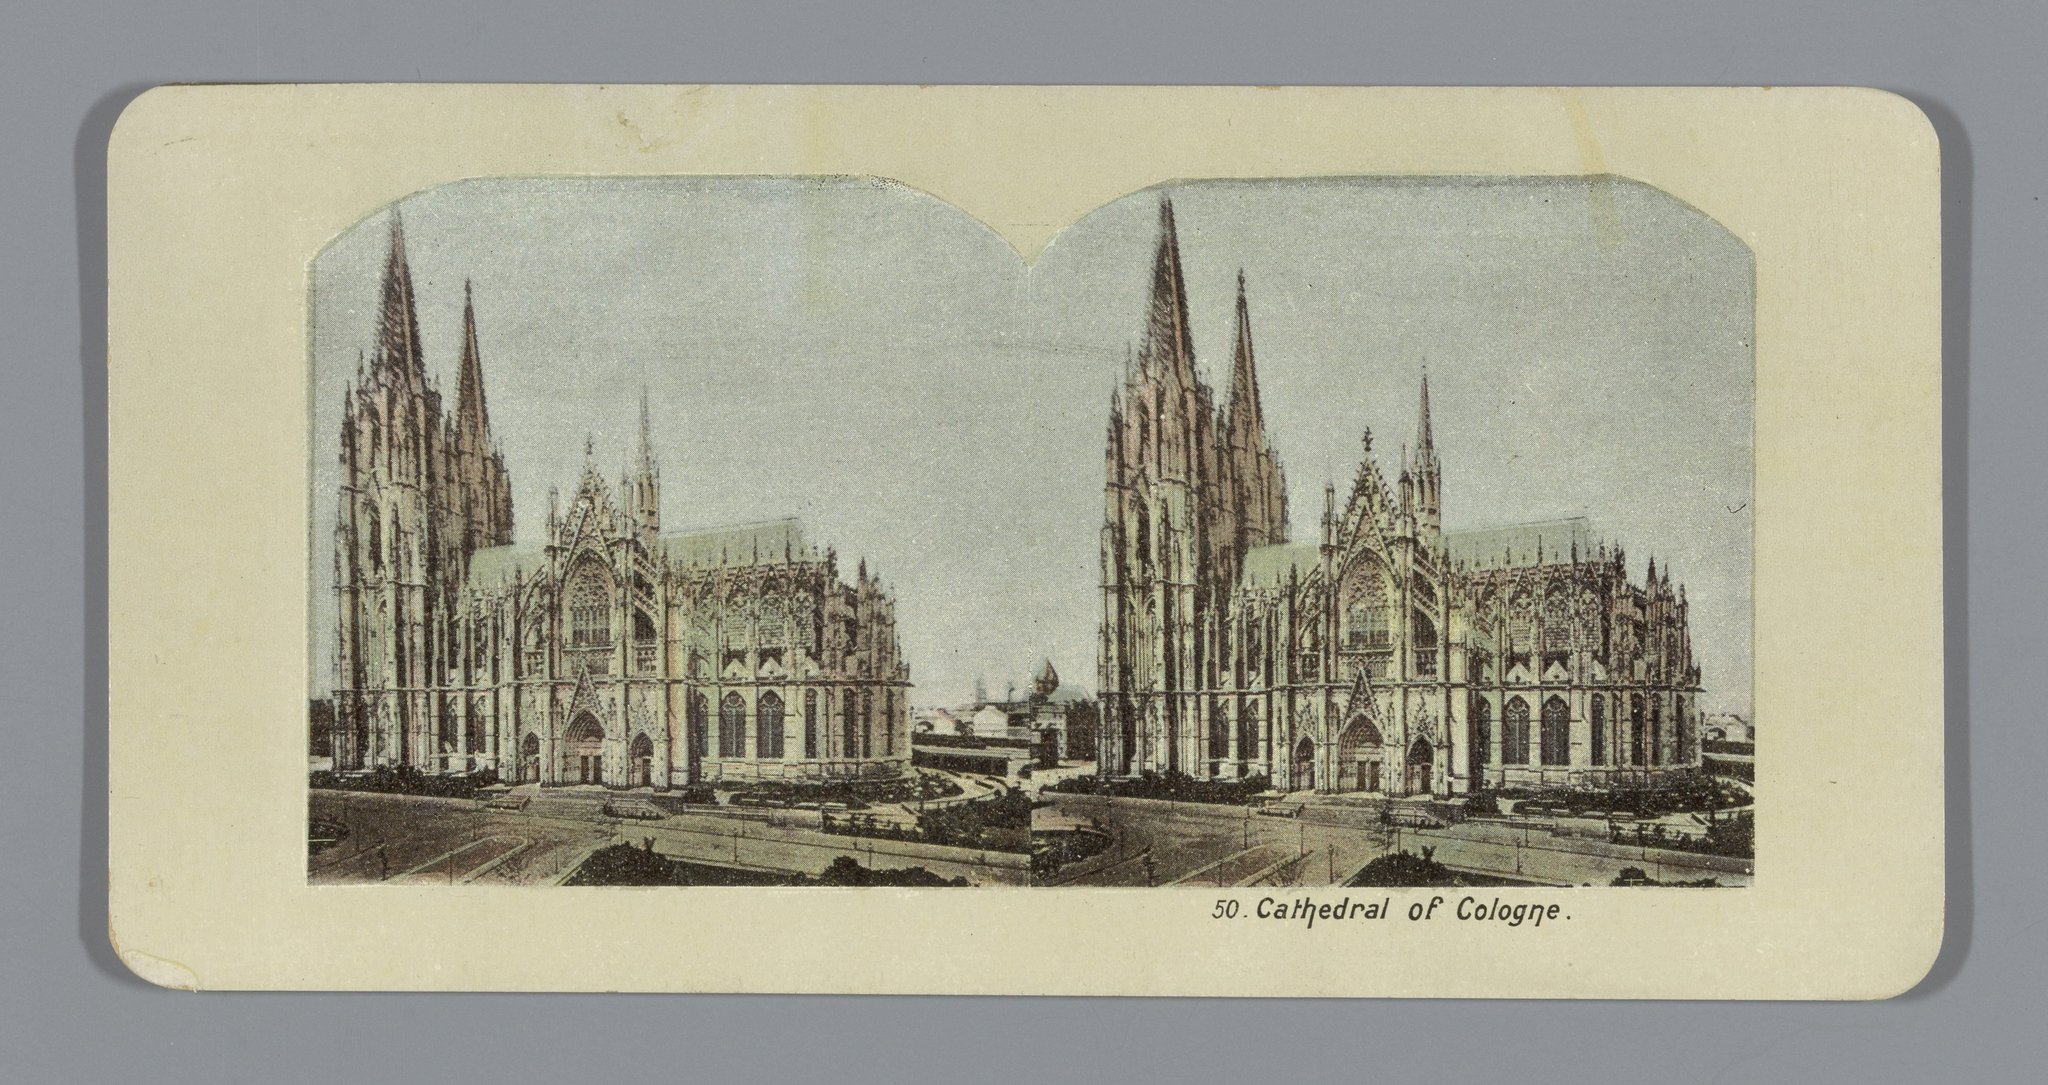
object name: photomechanical print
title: Cathedral of Cologne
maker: Anonymous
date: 1890-1910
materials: cardboard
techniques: hand coloring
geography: cologne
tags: façade (of house or building)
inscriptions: number: ‘50.’